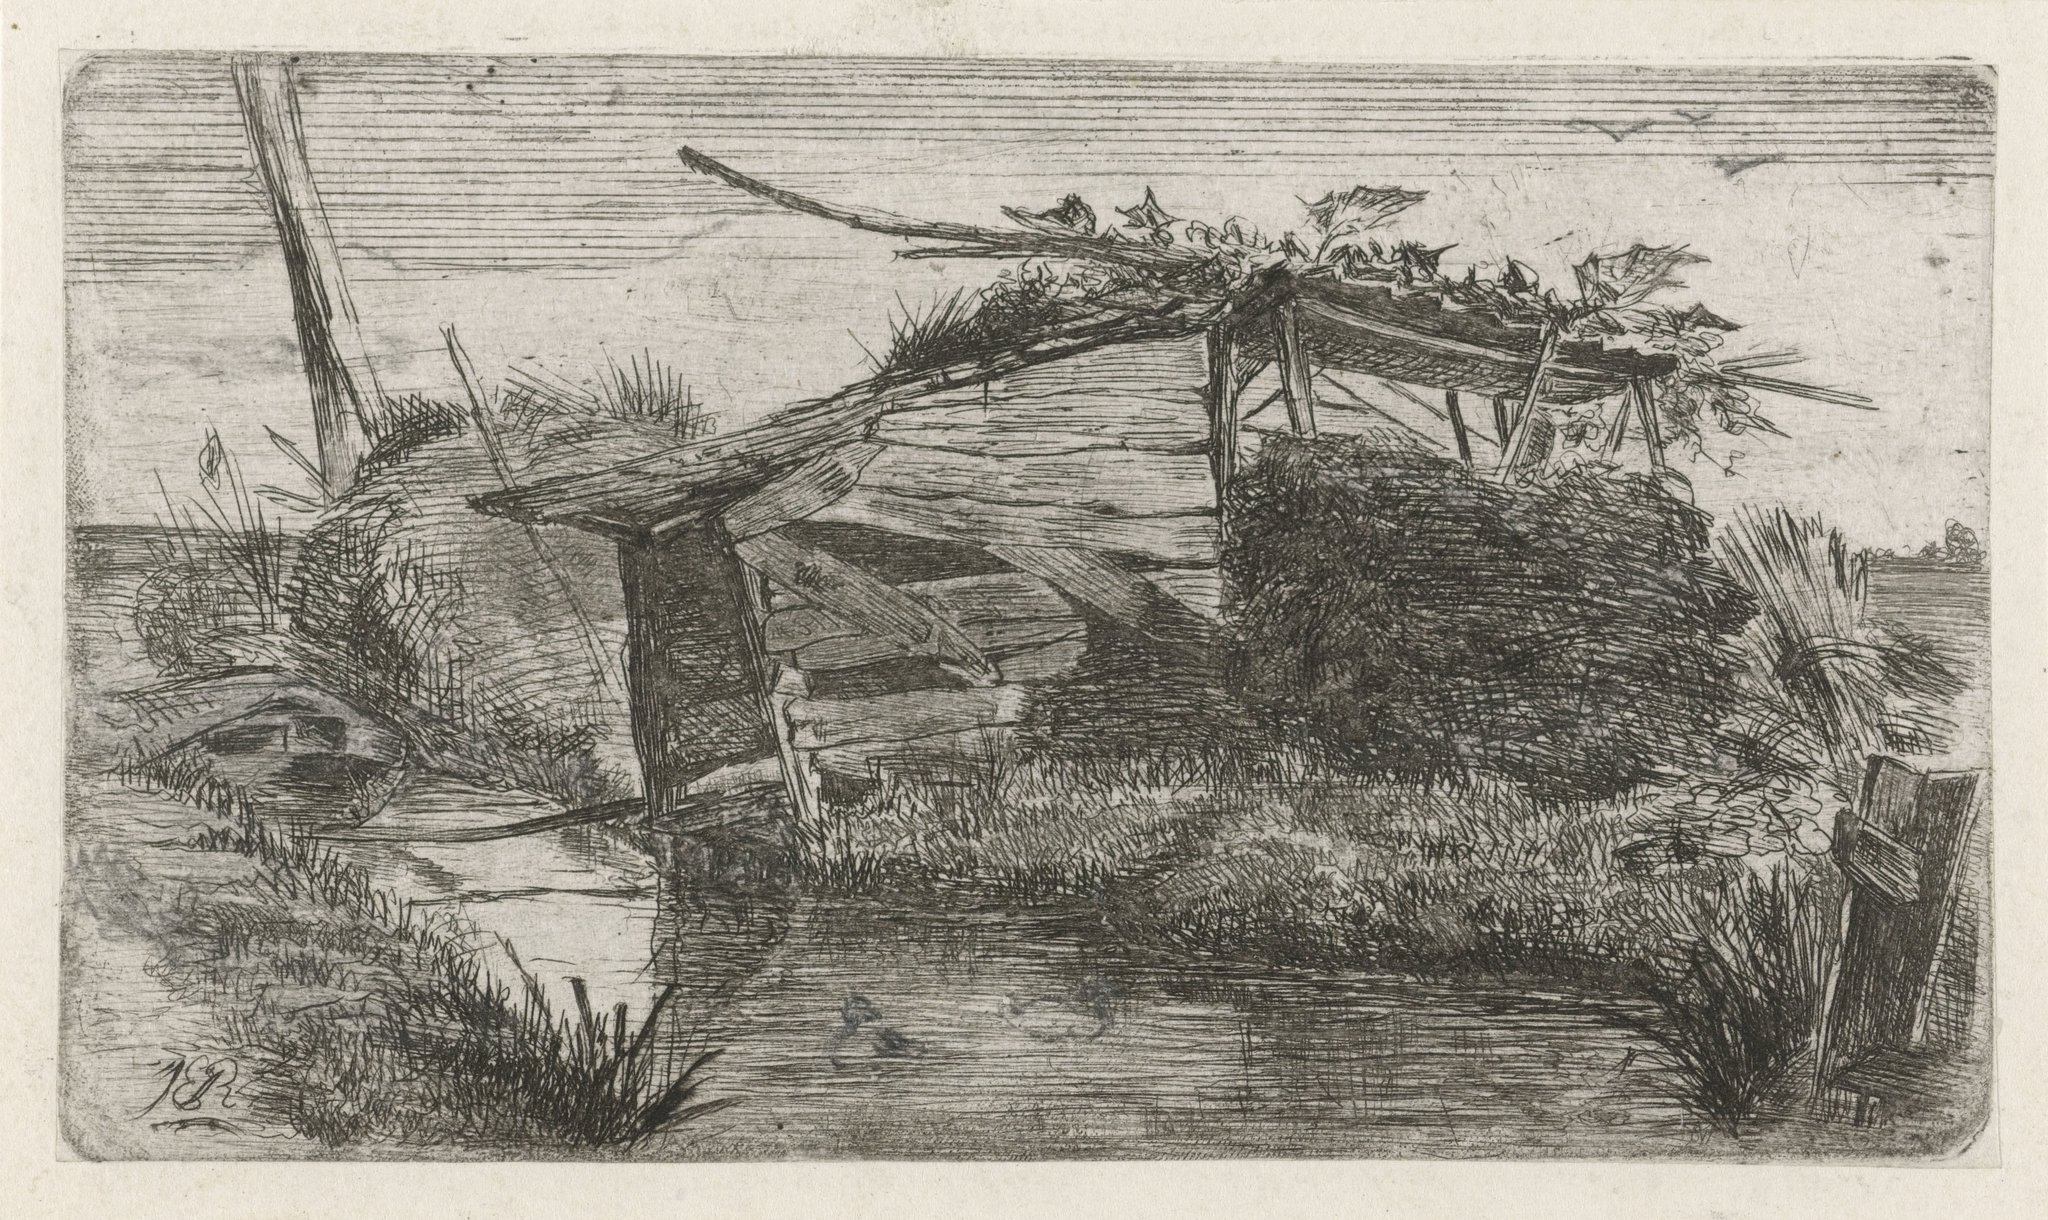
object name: print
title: Vervallen schuur aan een vaart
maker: johannes everhardus rijnboutt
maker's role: print maker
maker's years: 1839-1900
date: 1854-1884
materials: paper, pencil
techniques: etching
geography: netherlands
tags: canal, rowing-boat, canoe, etc., shed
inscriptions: collector's mark: Lugt 2228